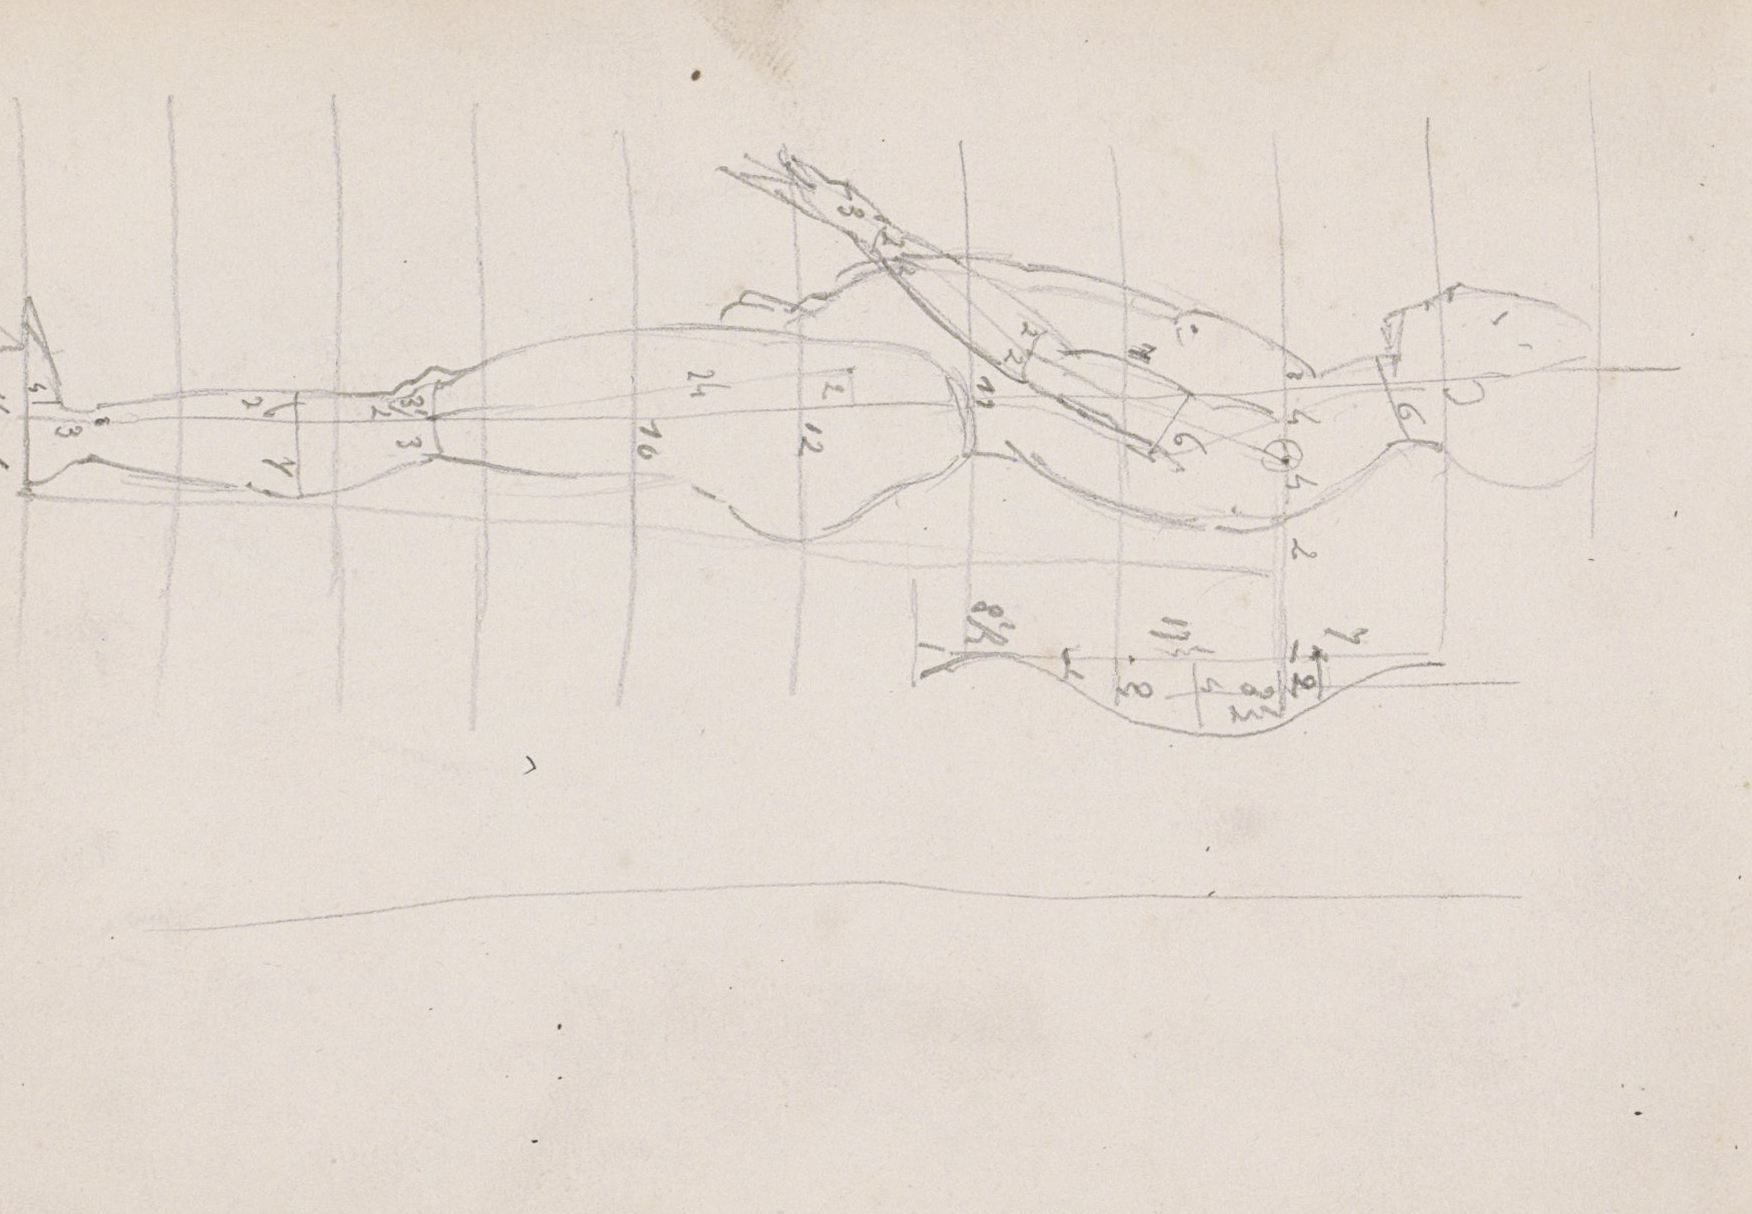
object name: sketchbook leaf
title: Staande naakte man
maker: jac van looij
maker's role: draughtsman, painter, print maker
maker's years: 1855-1930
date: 1877-1880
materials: paper, pencil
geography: amsterdam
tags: the (nude) human figure; 'corpo humano' (ripa)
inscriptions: annotation: ‘...’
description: Man van opzij gezien. Anatomische tekening op ruiten gebracht. Blad 17 verso uit een schetsboek met 27 bladen.